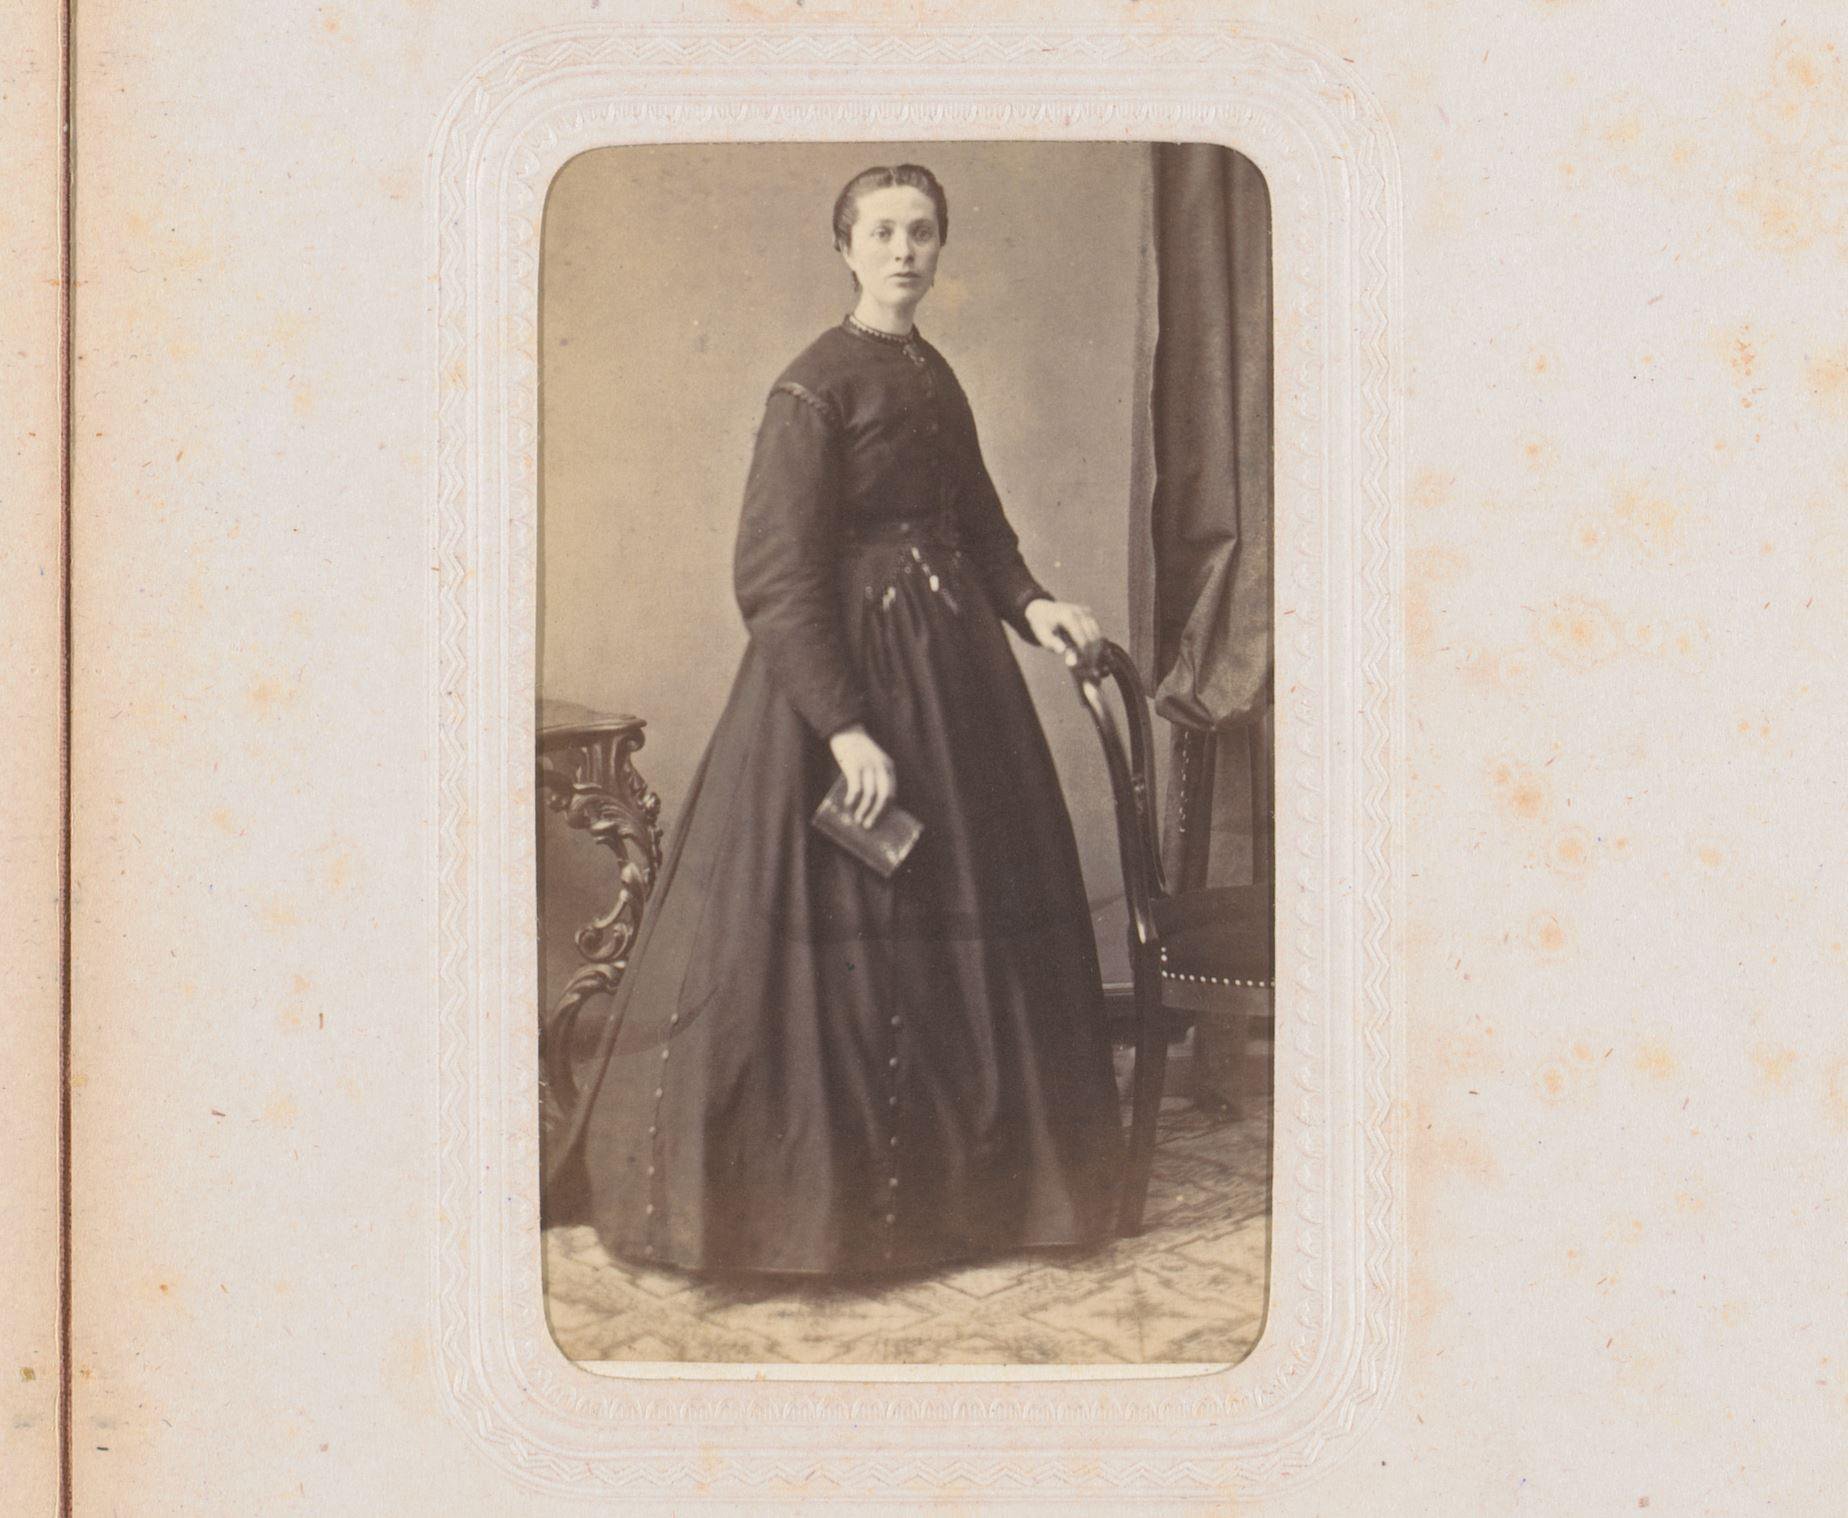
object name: carte de visite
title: Portret van een vrouw met boek in de hand, staand bij een stoel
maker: kornelis willem schorteldoek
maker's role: boekbinder, fotograaf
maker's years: 1800-1885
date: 1855-1885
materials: cardboard, photographic support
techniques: albumen print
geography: gorinchem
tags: historical persons - bb - woman, book, standing figure - aa - female human figure, chair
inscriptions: inscription: ‘SCHORTELDOEK/ PHOTOGRAAF/ GORINCHEM/ Groote Markt’